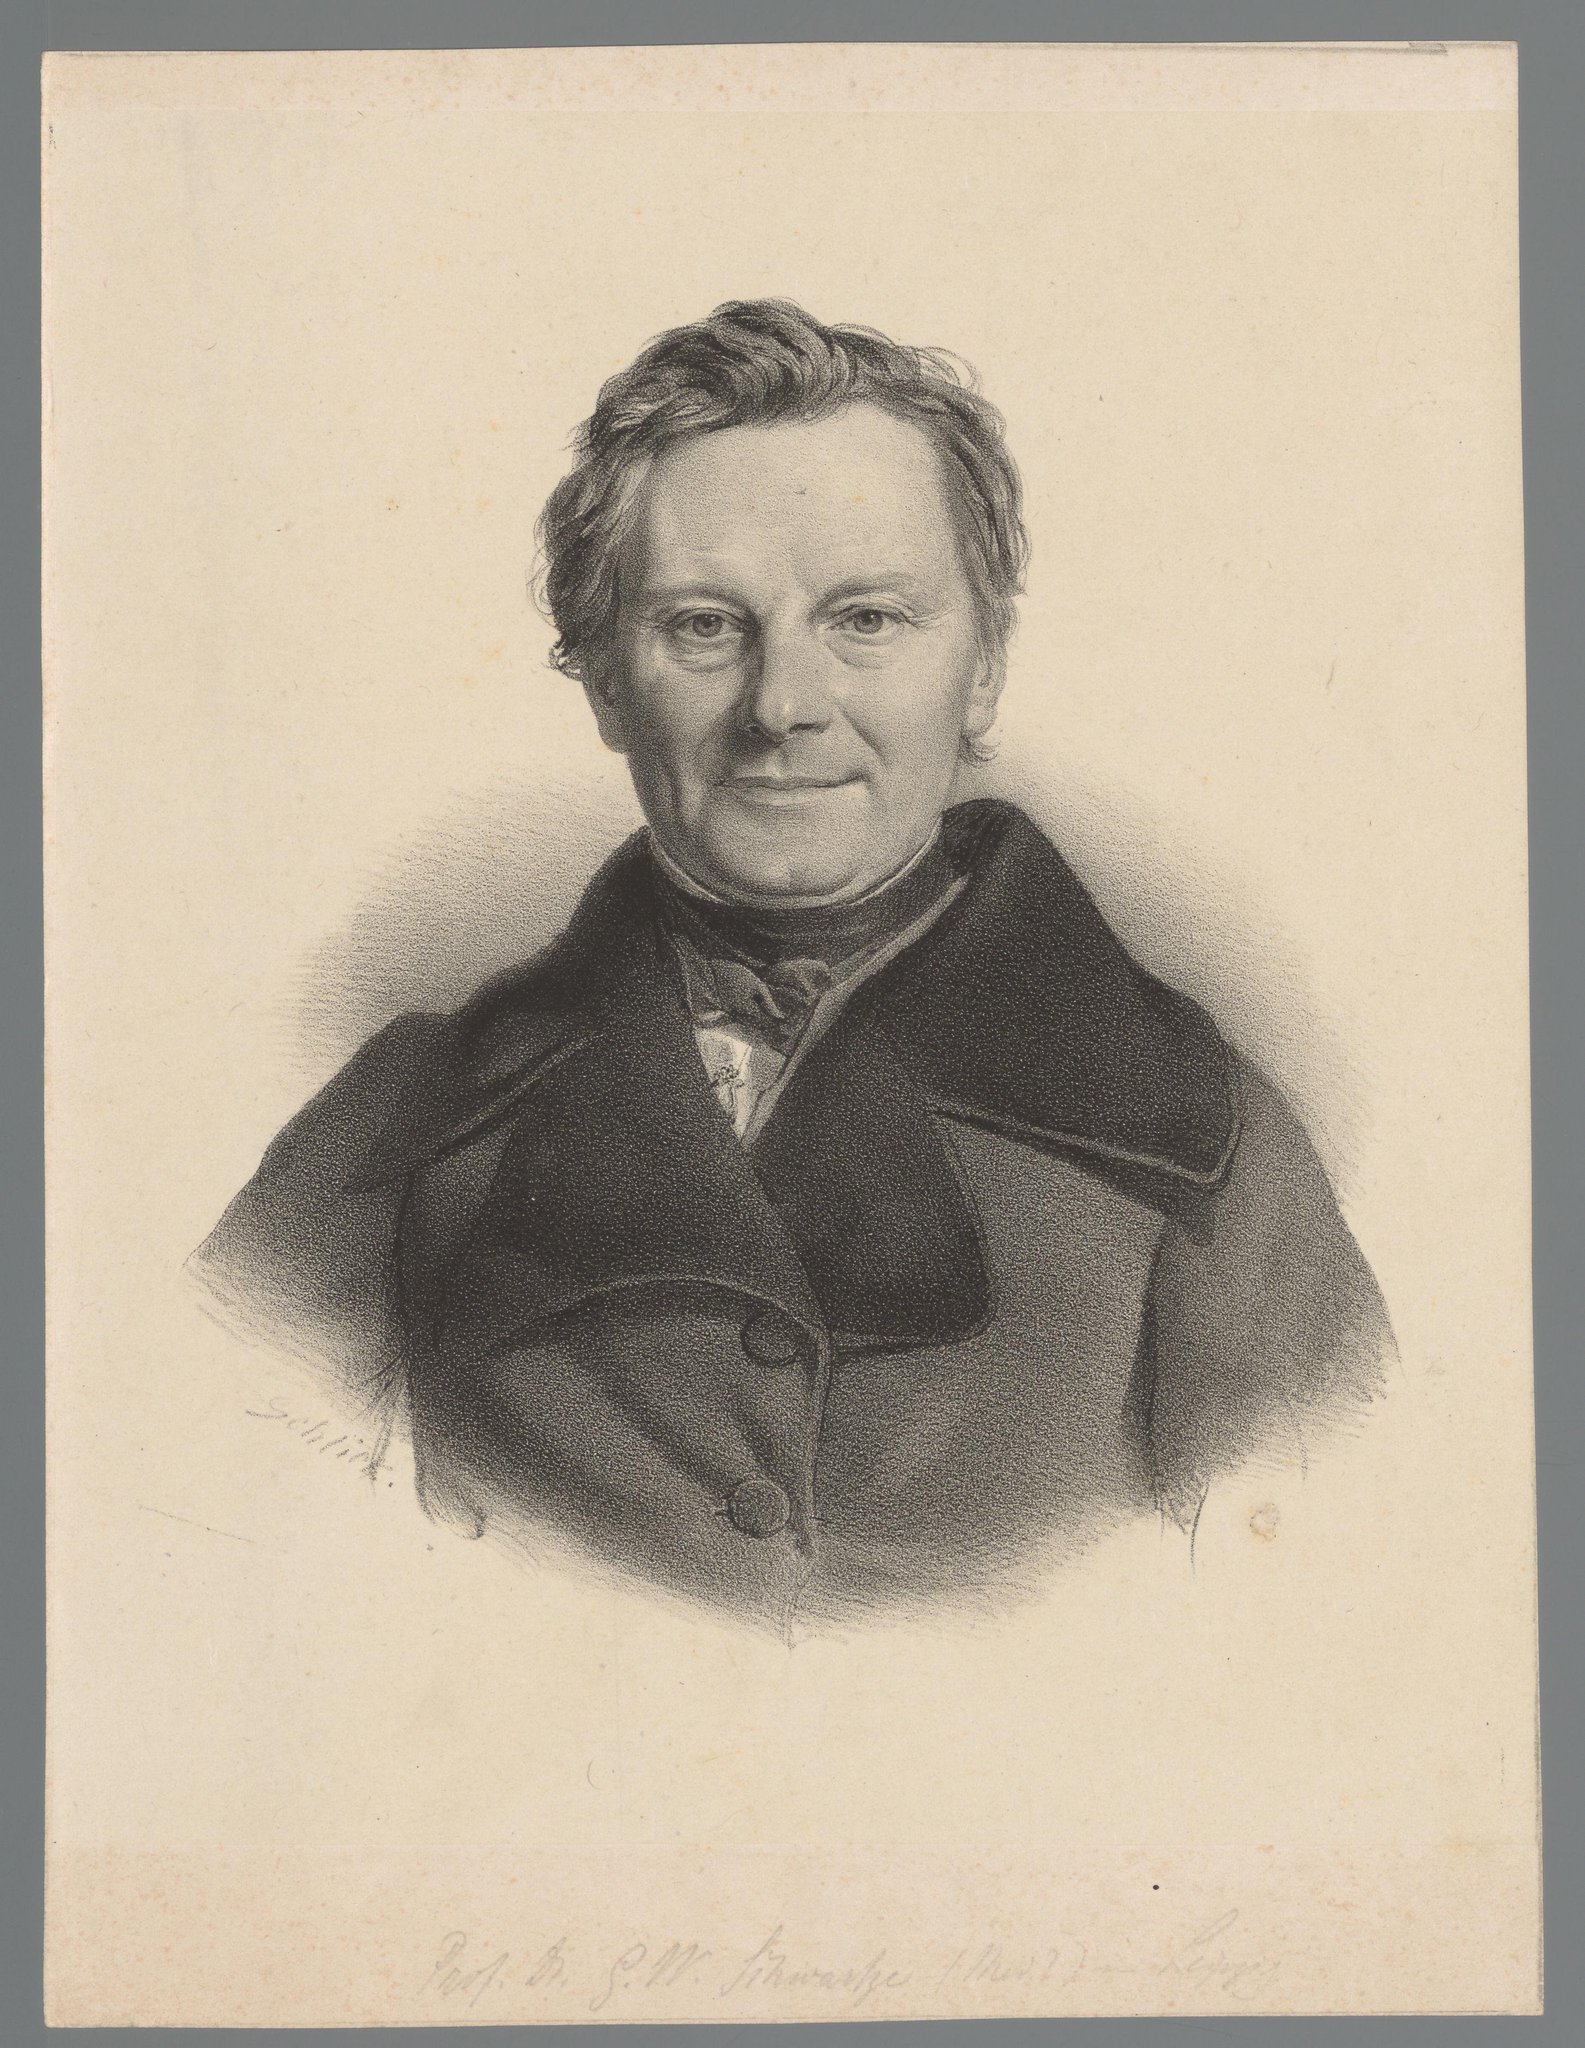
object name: print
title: Portret van G.W. Schwartze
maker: gustav schlick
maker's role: print maker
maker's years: 1804-1869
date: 1814-1869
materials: paper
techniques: lithograph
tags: medicine, medical science (+ portrait of scholar, scientist), historical persons not known by name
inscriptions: collector's mark: Lugt 2228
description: Portret van een verder onbekende medicus met de naam G.W. Schwartze.